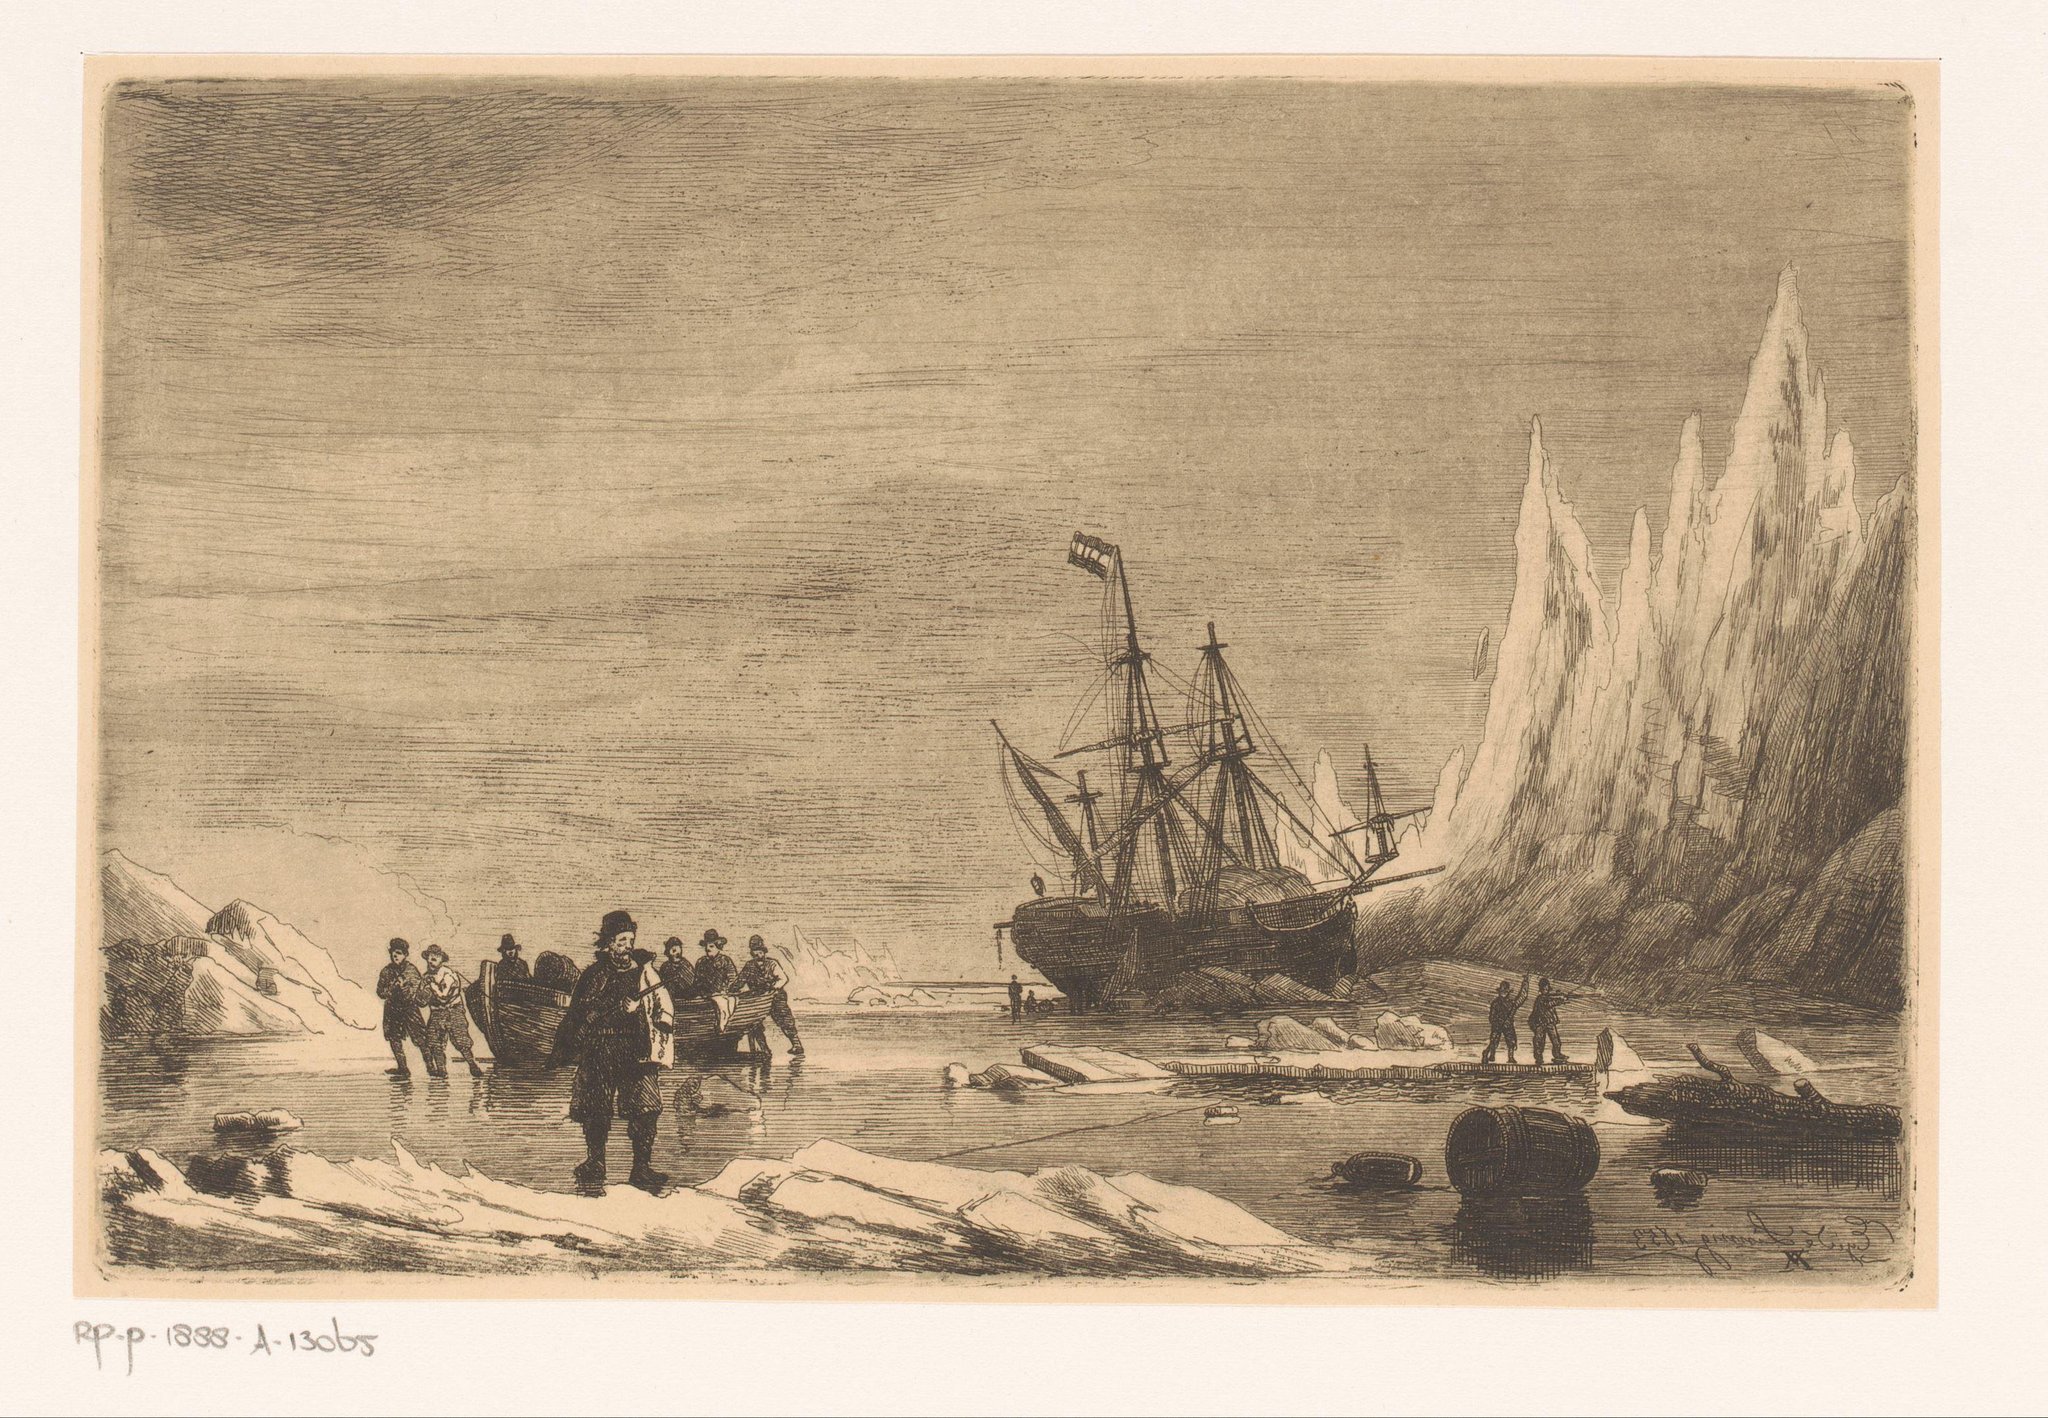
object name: print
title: Overwintering op Nova Zembla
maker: egidius linnig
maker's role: draughtsman, print maker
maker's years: 1821-1860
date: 1853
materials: paper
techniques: aquatint, etching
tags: shipwreck, landscapes in polar regions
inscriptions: collector's mark: Lugt 2228